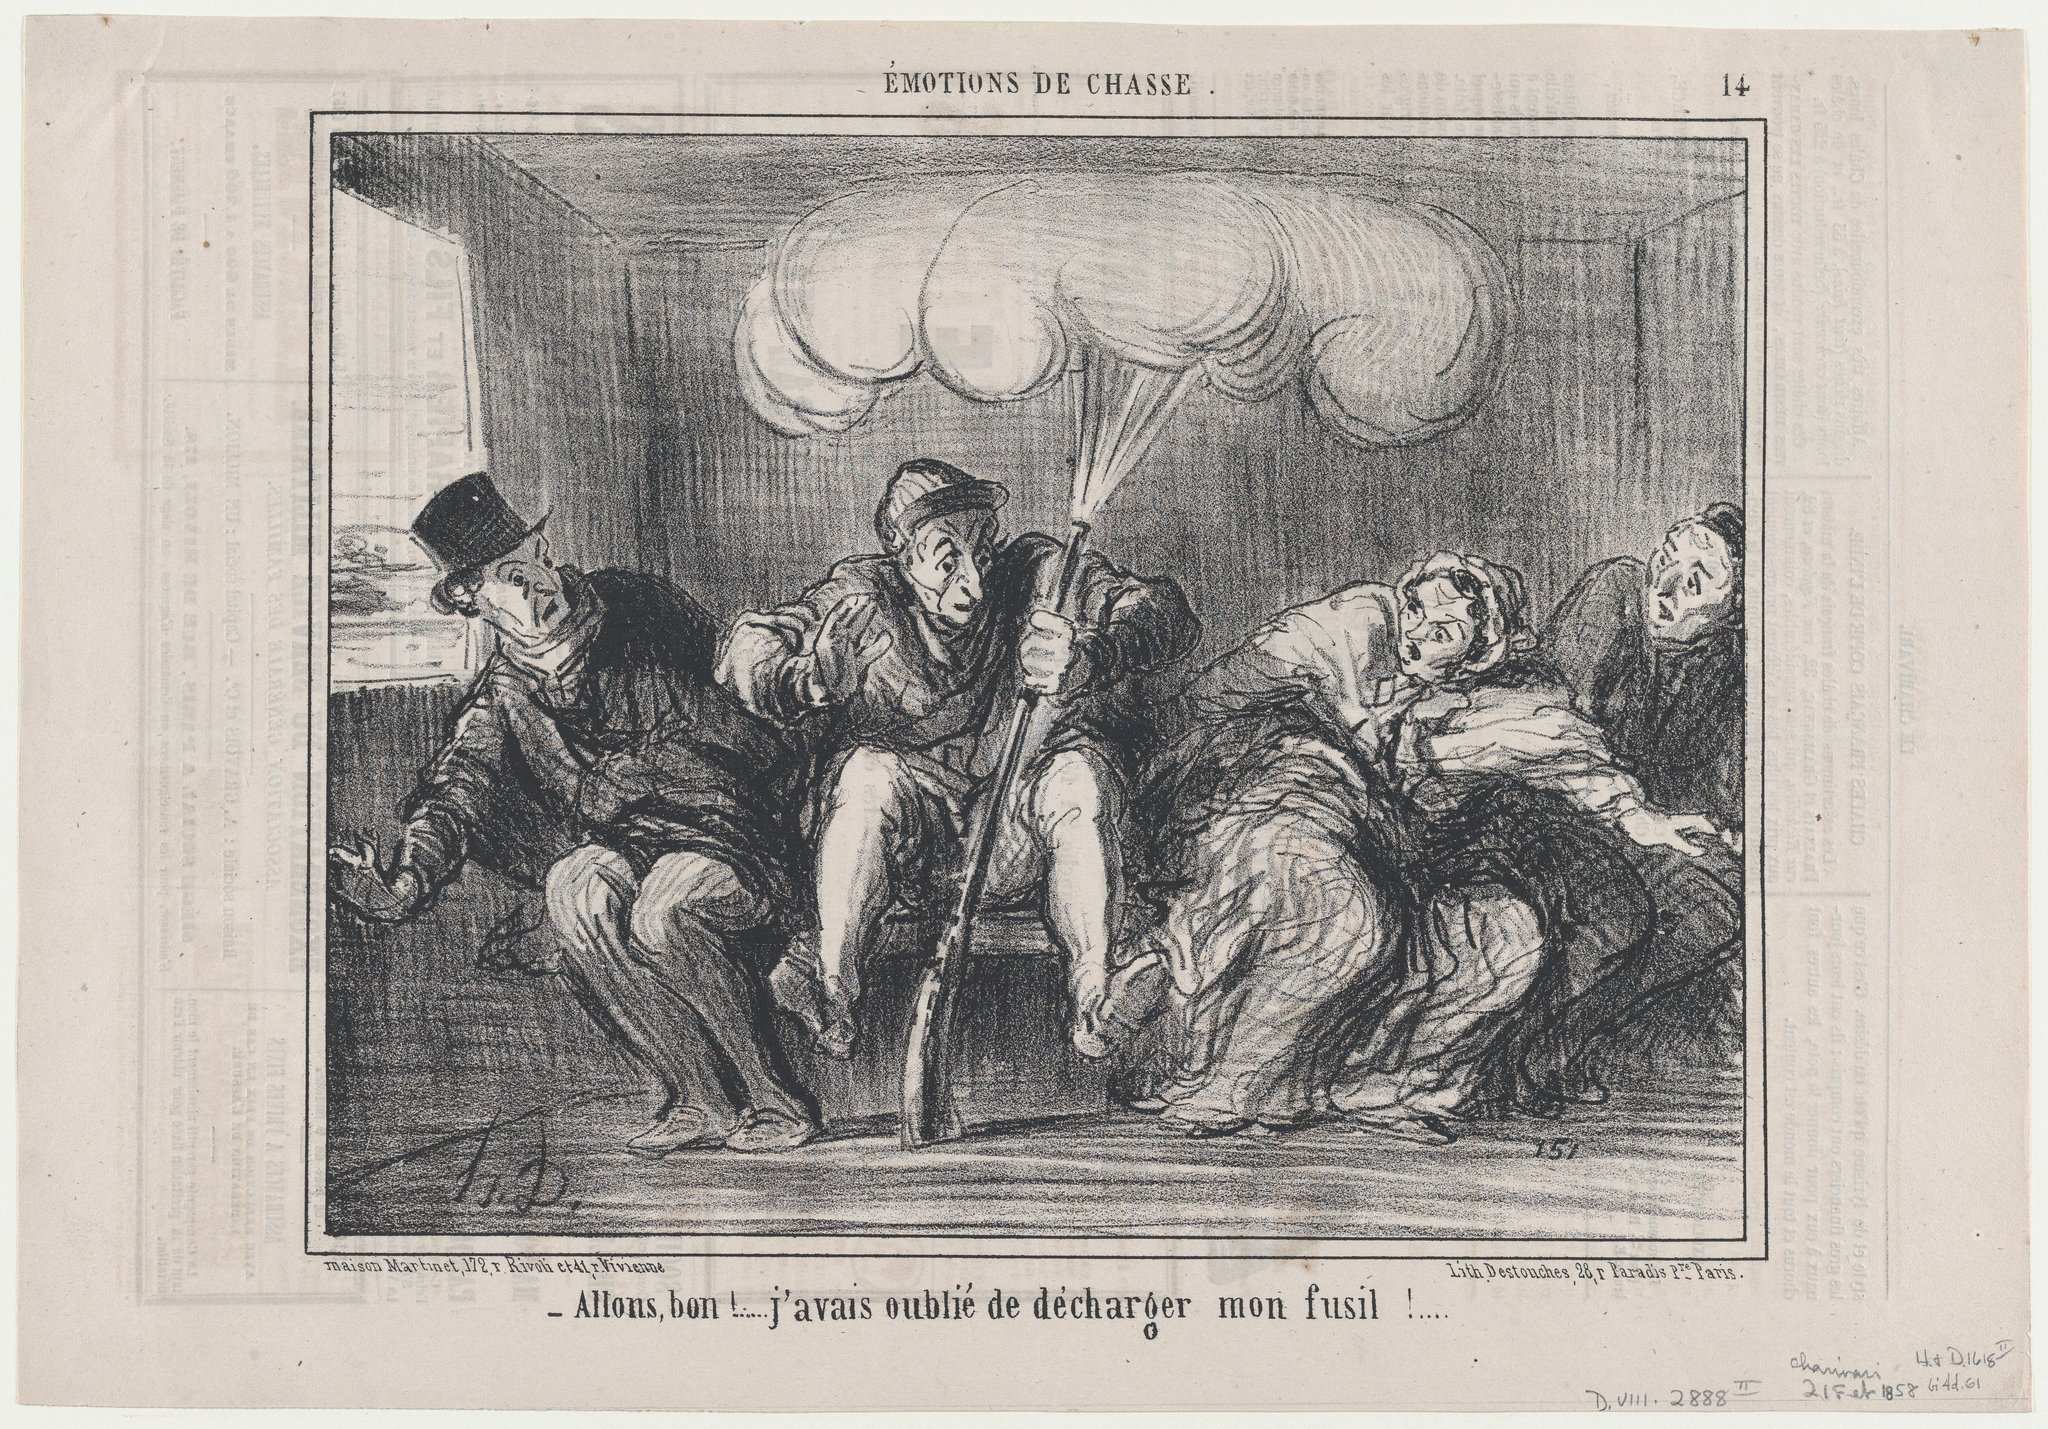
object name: print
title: Allons bon!..... j'avais oublié de décharger mon fusil!...., from Émotions de Chasse, published in Le Charivari, February 21, 1858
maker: honoré daumier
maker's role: artist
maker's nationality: french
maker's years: 1808-1879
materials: paper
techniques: lithograph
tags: satire,men,women